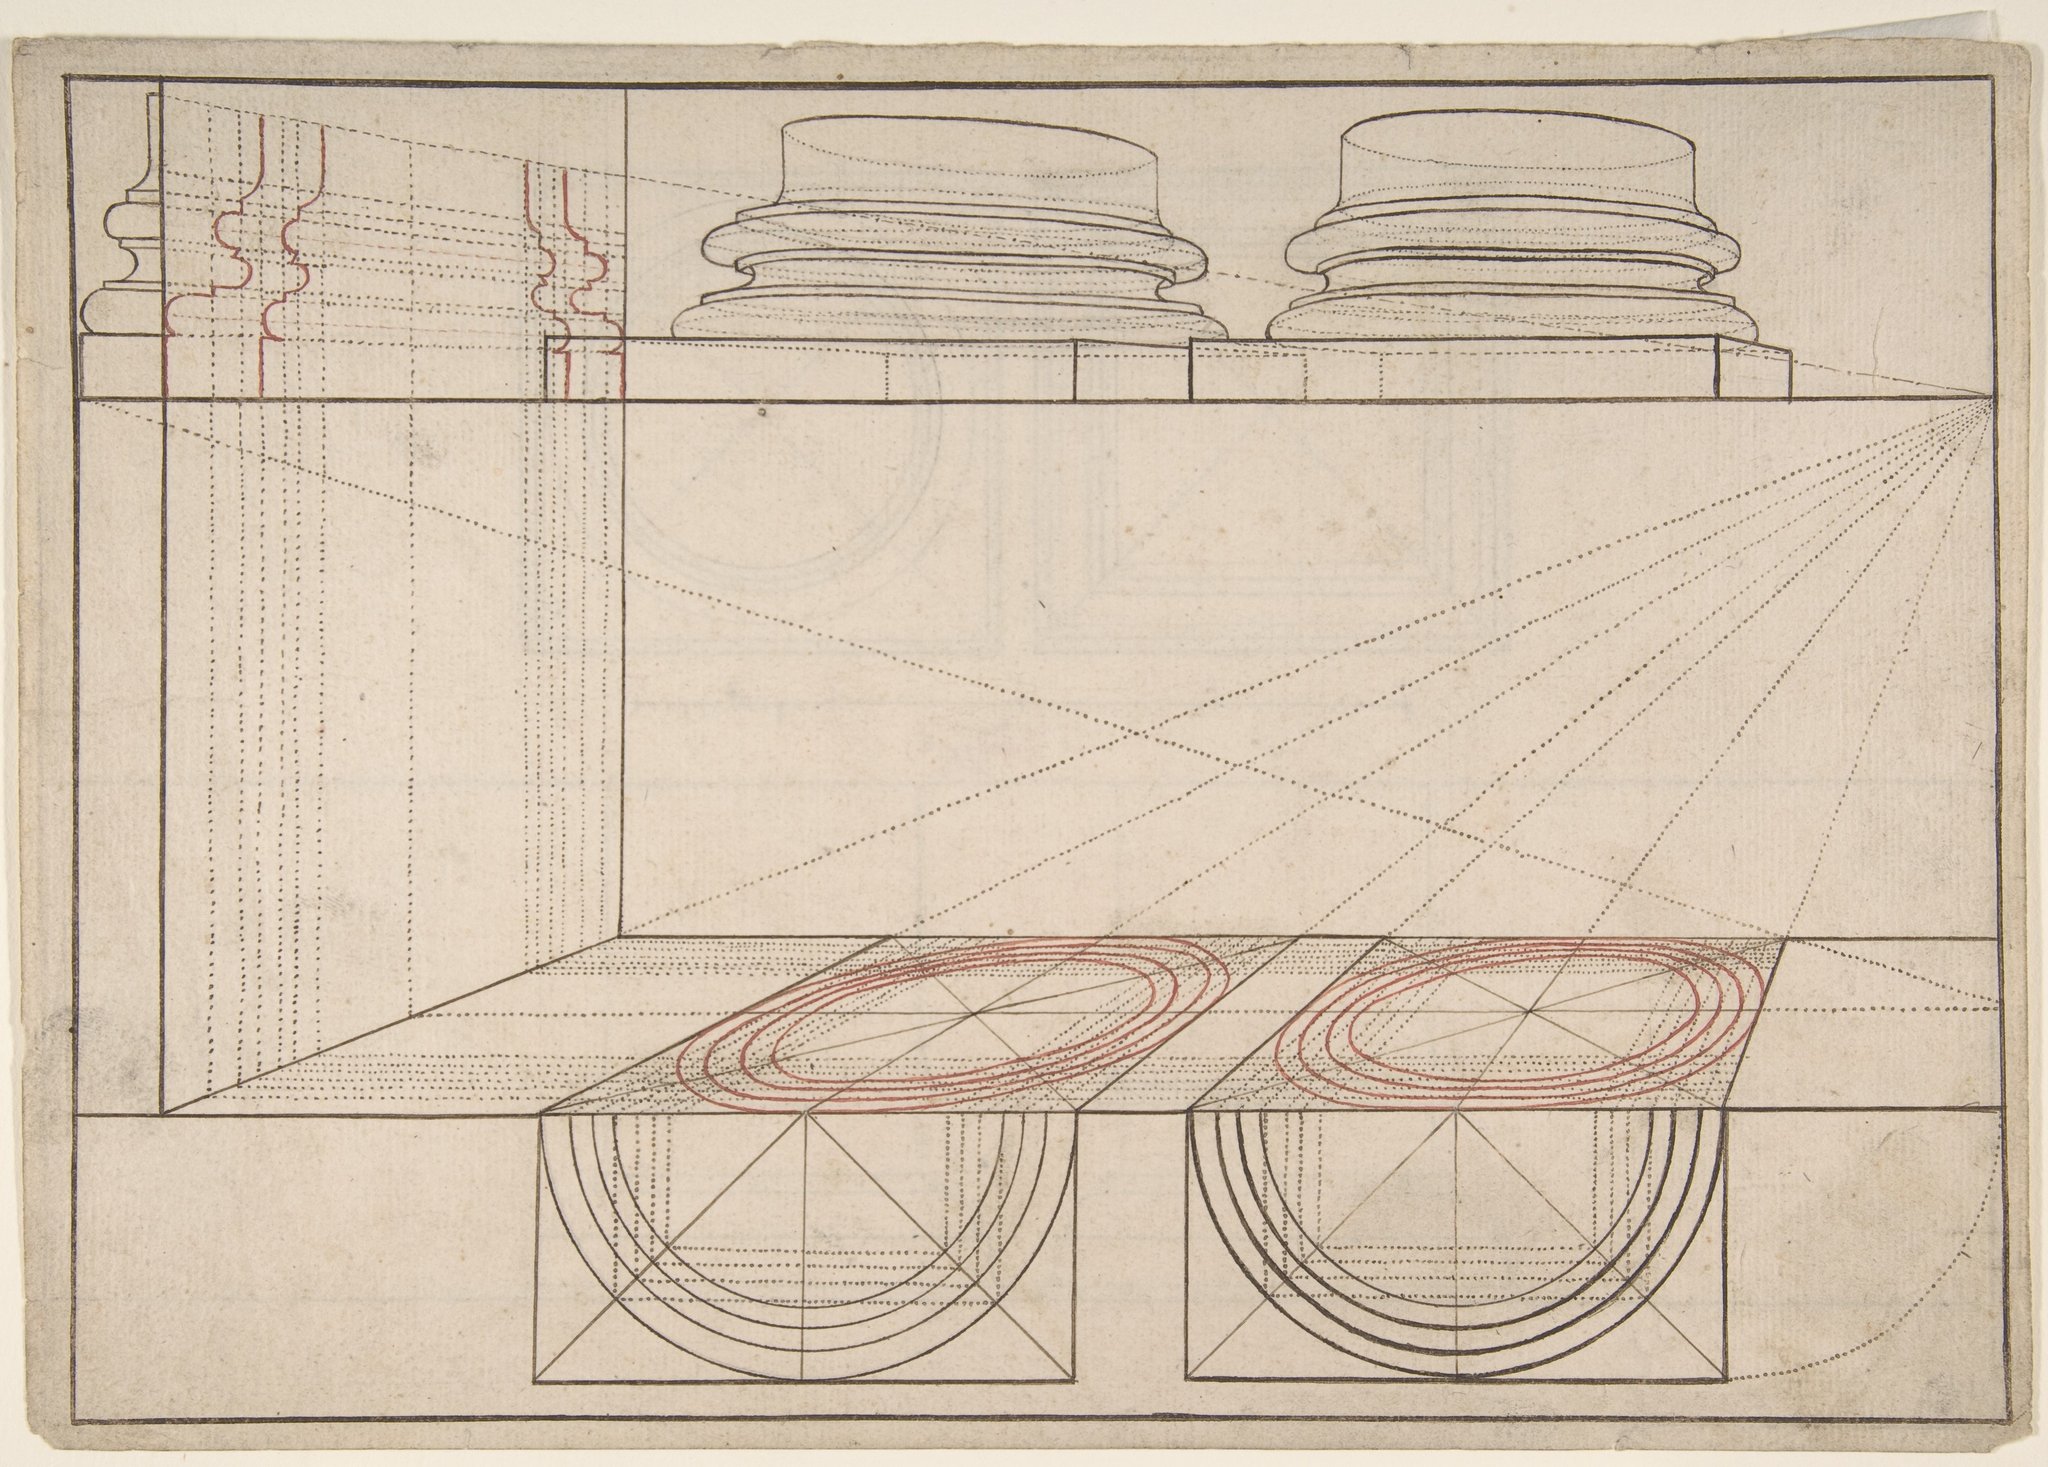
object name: drawing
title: Architectural Perspective Study Showing Two Column Bases (recto); Architectural Perspective Study Showing Column Capital and a Measurement Key (verso)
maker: anonymous, italian, 17th century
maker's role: artist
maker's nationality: italian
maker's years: 1600-1700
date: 1601-1700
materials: graphite, ink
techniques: pen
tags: architecture